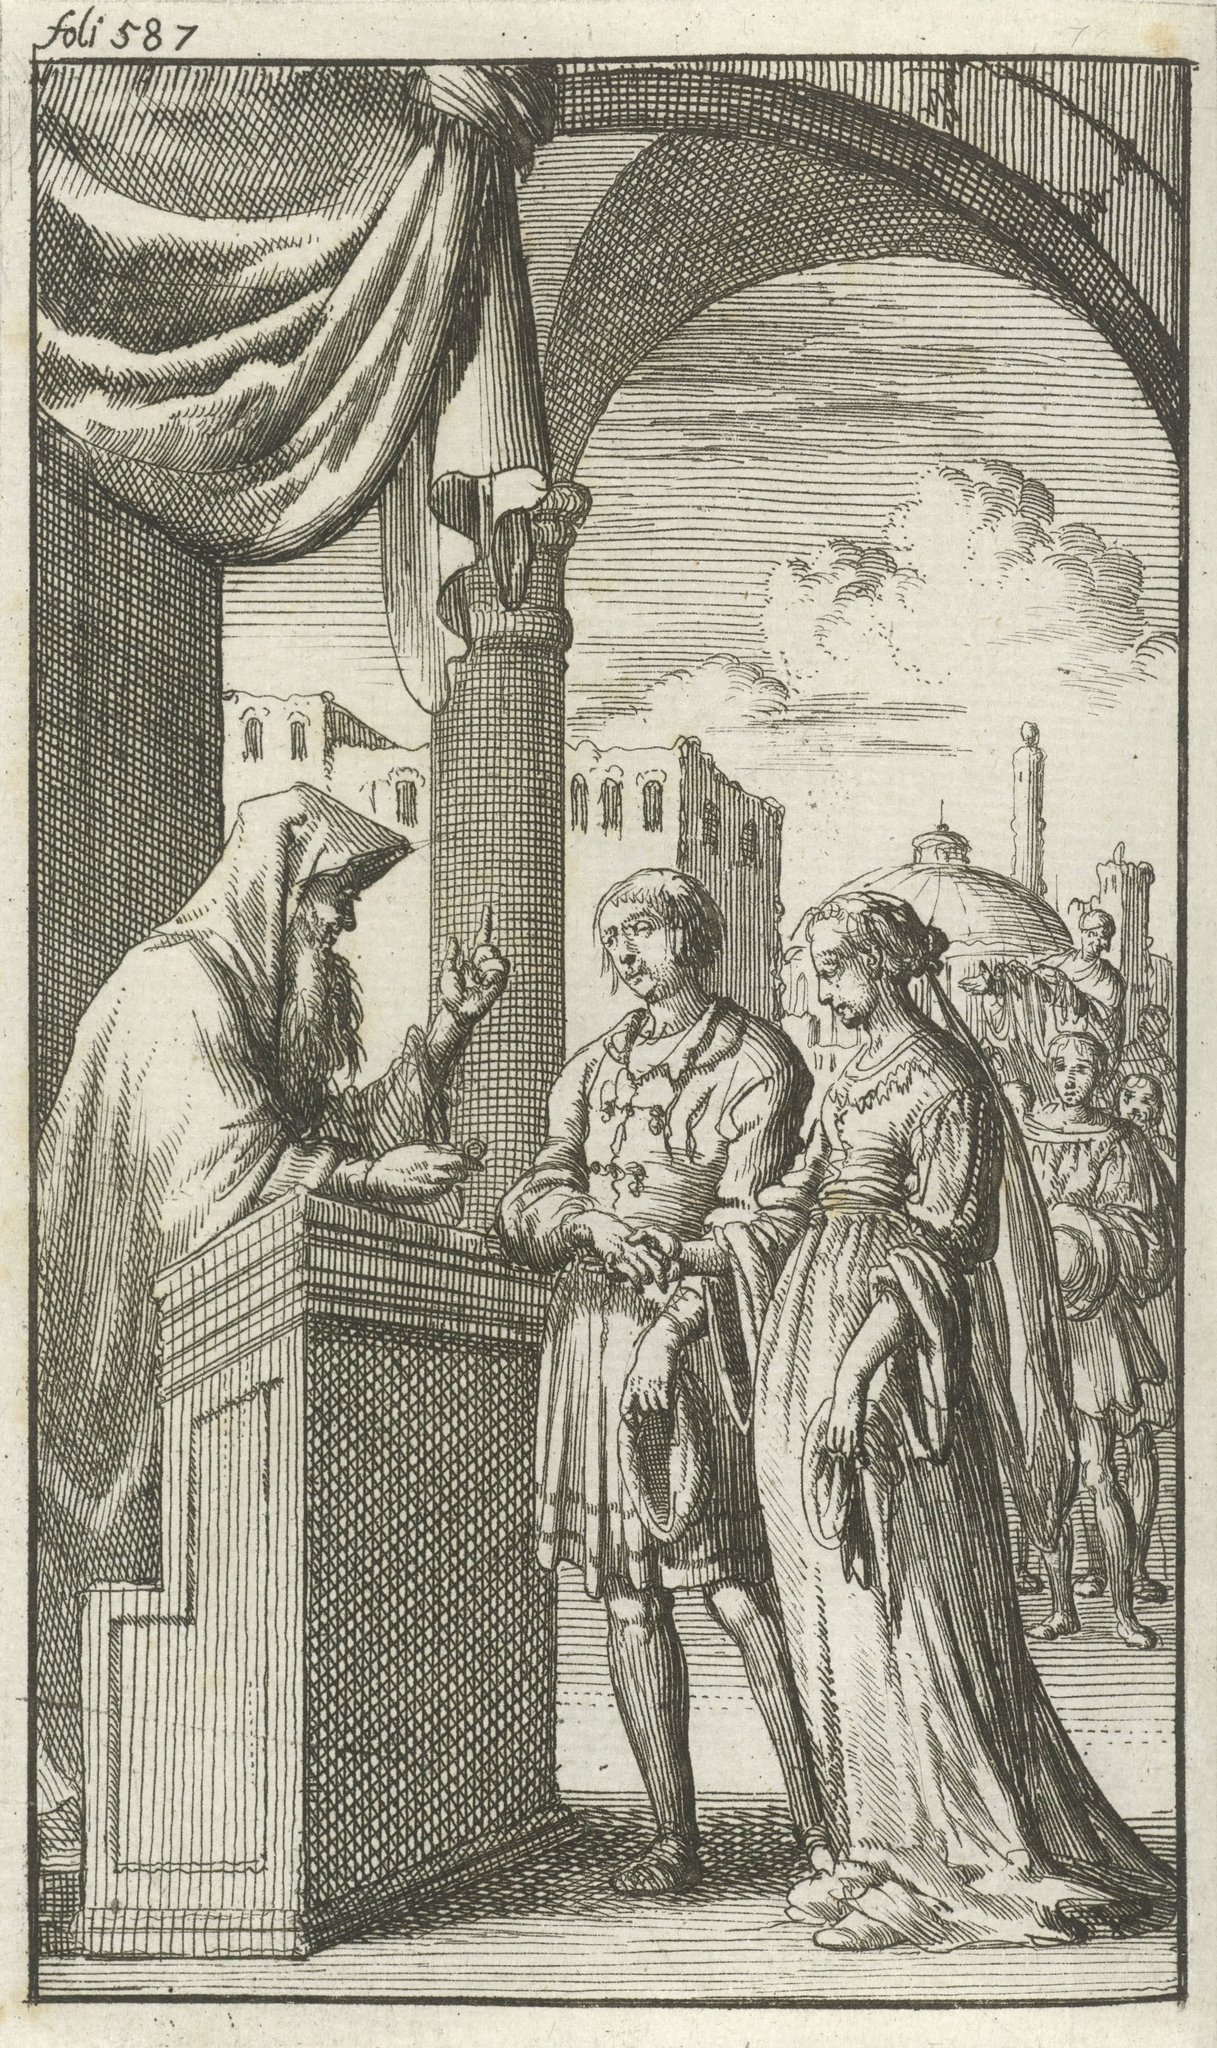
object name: book illustration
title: Huwelijksinzegening door een joodse priester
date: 1685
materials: paper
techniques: etching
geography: amsterdam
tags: 'kiddushin', jewish wedding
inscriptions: collector's mark: Lugt 2228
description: Illustratie uit: Hondorffius, Andreas. De tien geboden des Heeren. Amsterdam: Jan Bouman, 1685.